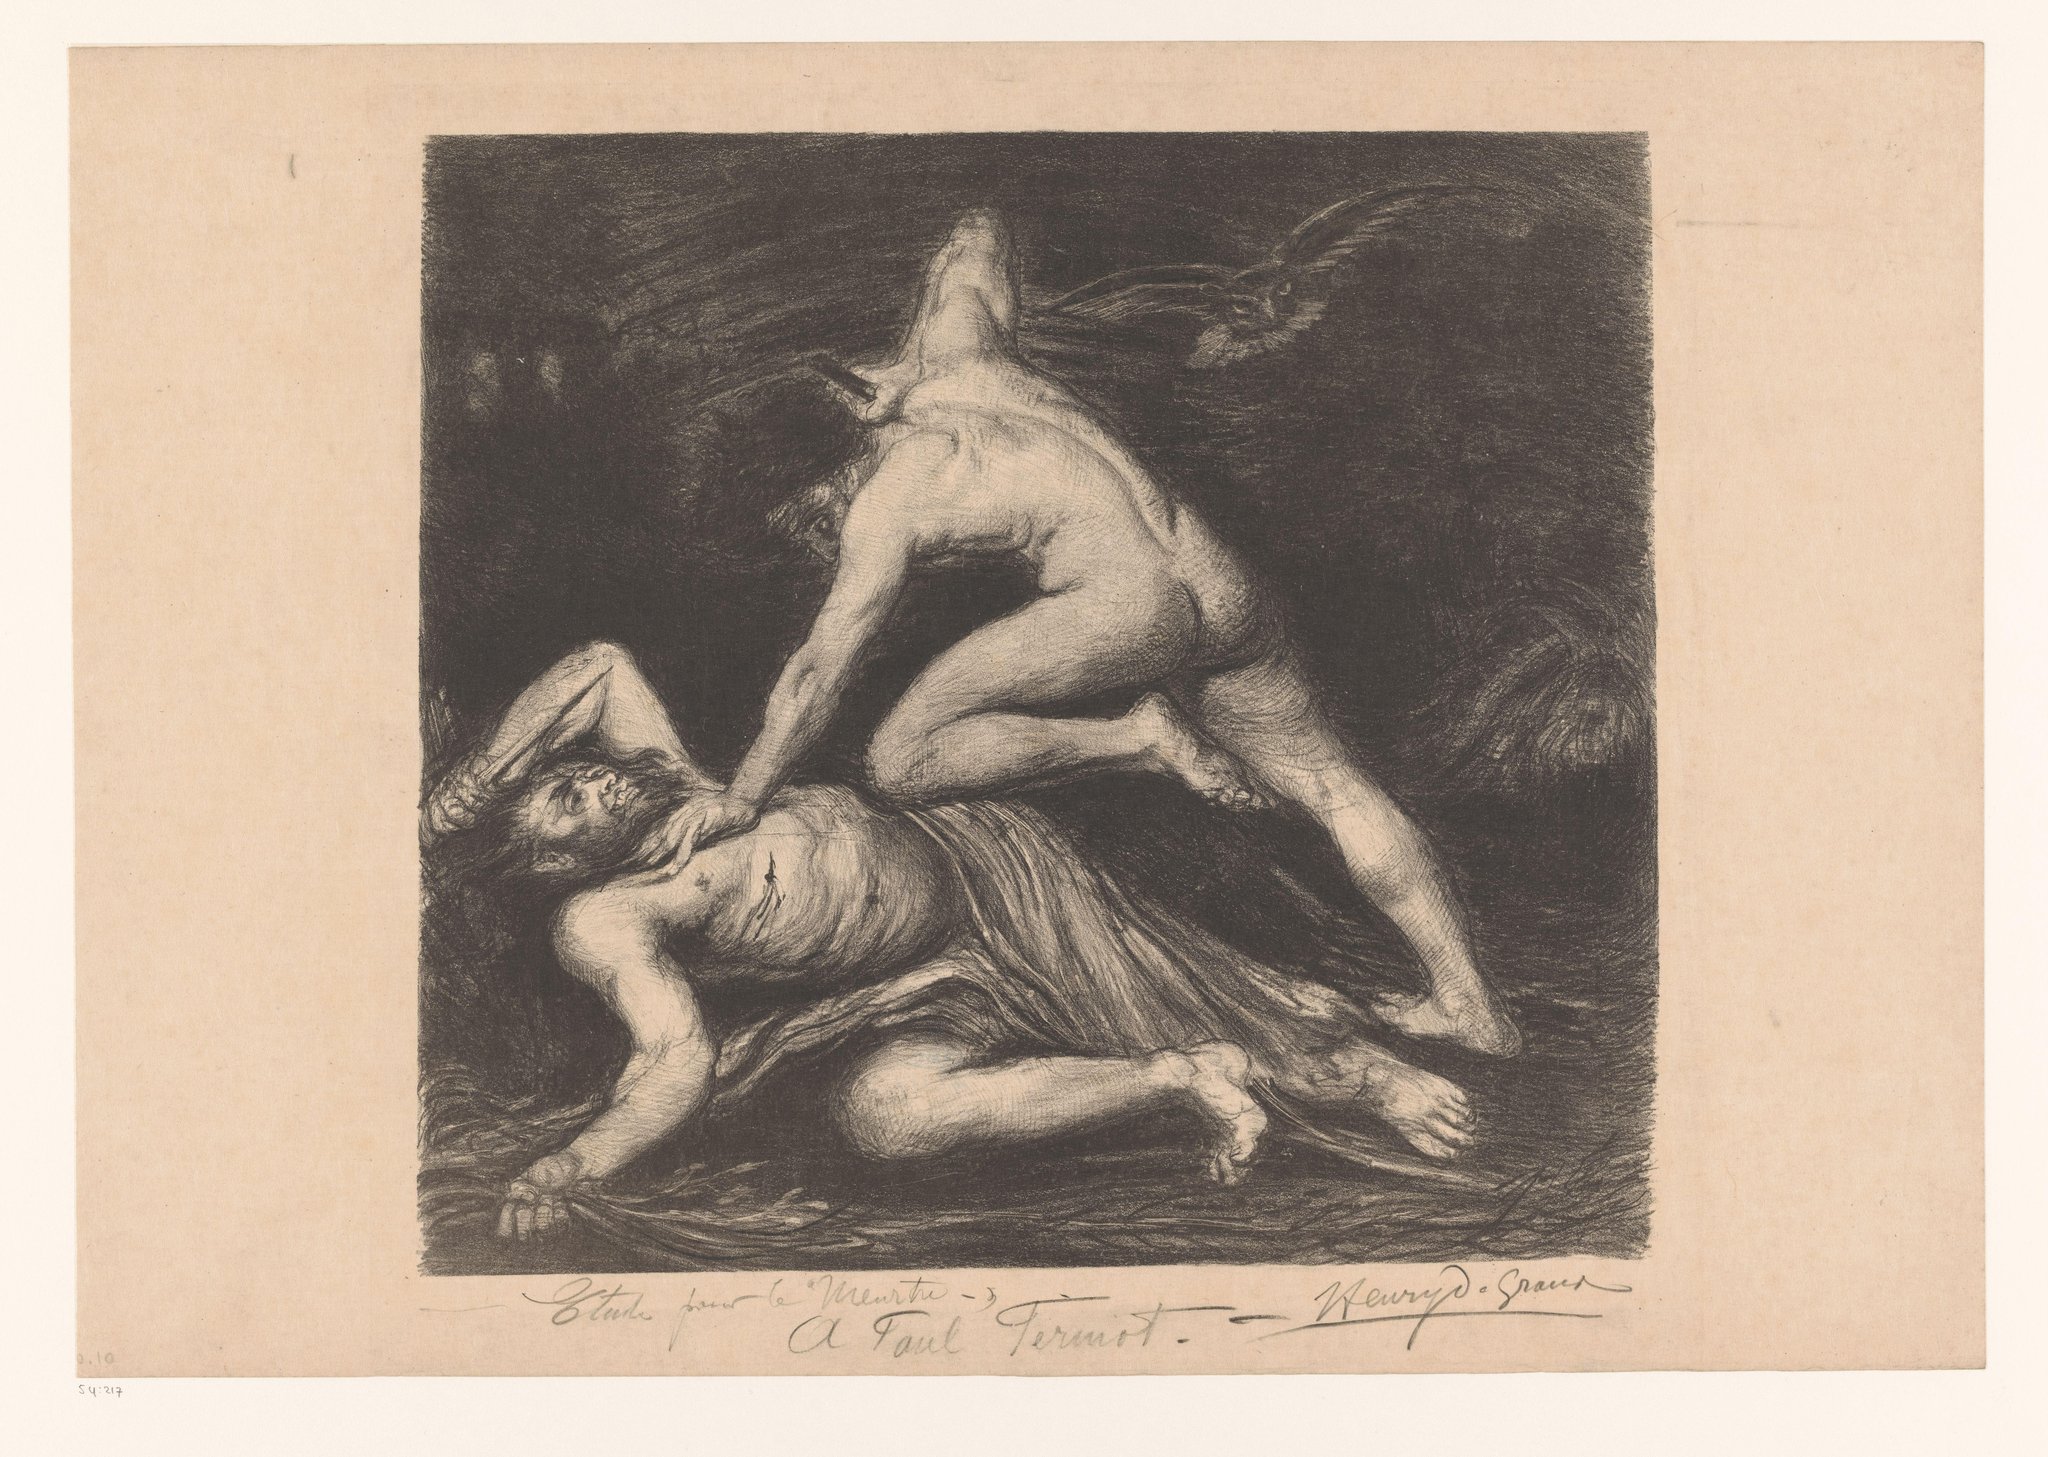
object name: print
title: Twee naakte figuren met elkaar in strijd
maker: henri de groux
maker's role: painter, print maker, sculptor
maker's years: 1866-1930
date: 1877-1930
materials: paper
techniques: lithograph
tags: the (nude) human figure; 'corpo humano' (ripa), owls, fighting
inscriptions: collector's mark: Lugt 2228, inscription: ‘Etude pour le Meurtre a Paul Ferniot’, collector's mark: Lugt 2760